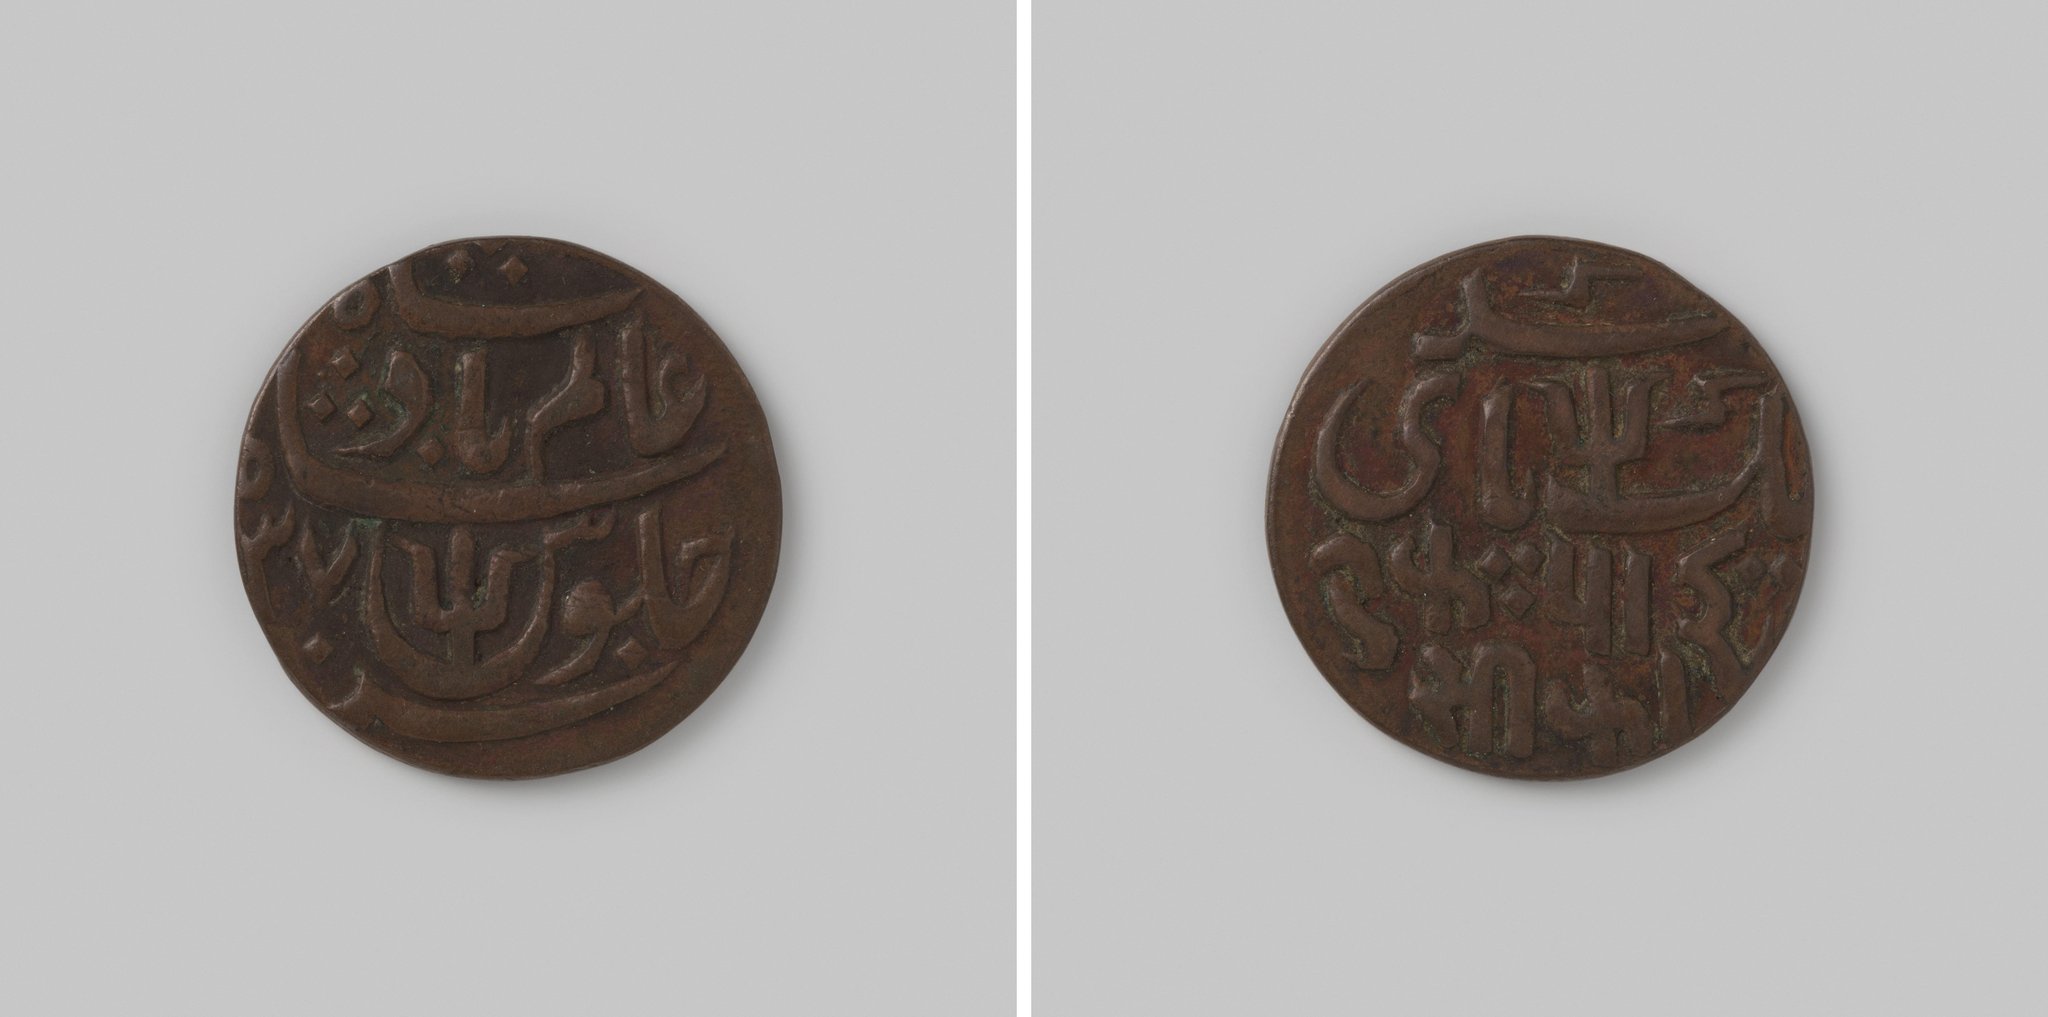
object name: coin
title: Pice uit Bengalen in India van de Engelse Oostindische Compagnie (EIC) op naam van Sjah Alam I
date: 1815-1821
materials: copper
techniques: striking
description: Koperen munt. Voorzijde: in Arabische lettertekens in drie regels opschrift. Op onderste regel drietand. Keerzijde: in Arabische lettertekens in twee regels opschrift met op tweede regel drietand. Daaronder in twee regels opschrift in het Bengali. Gladde rand.